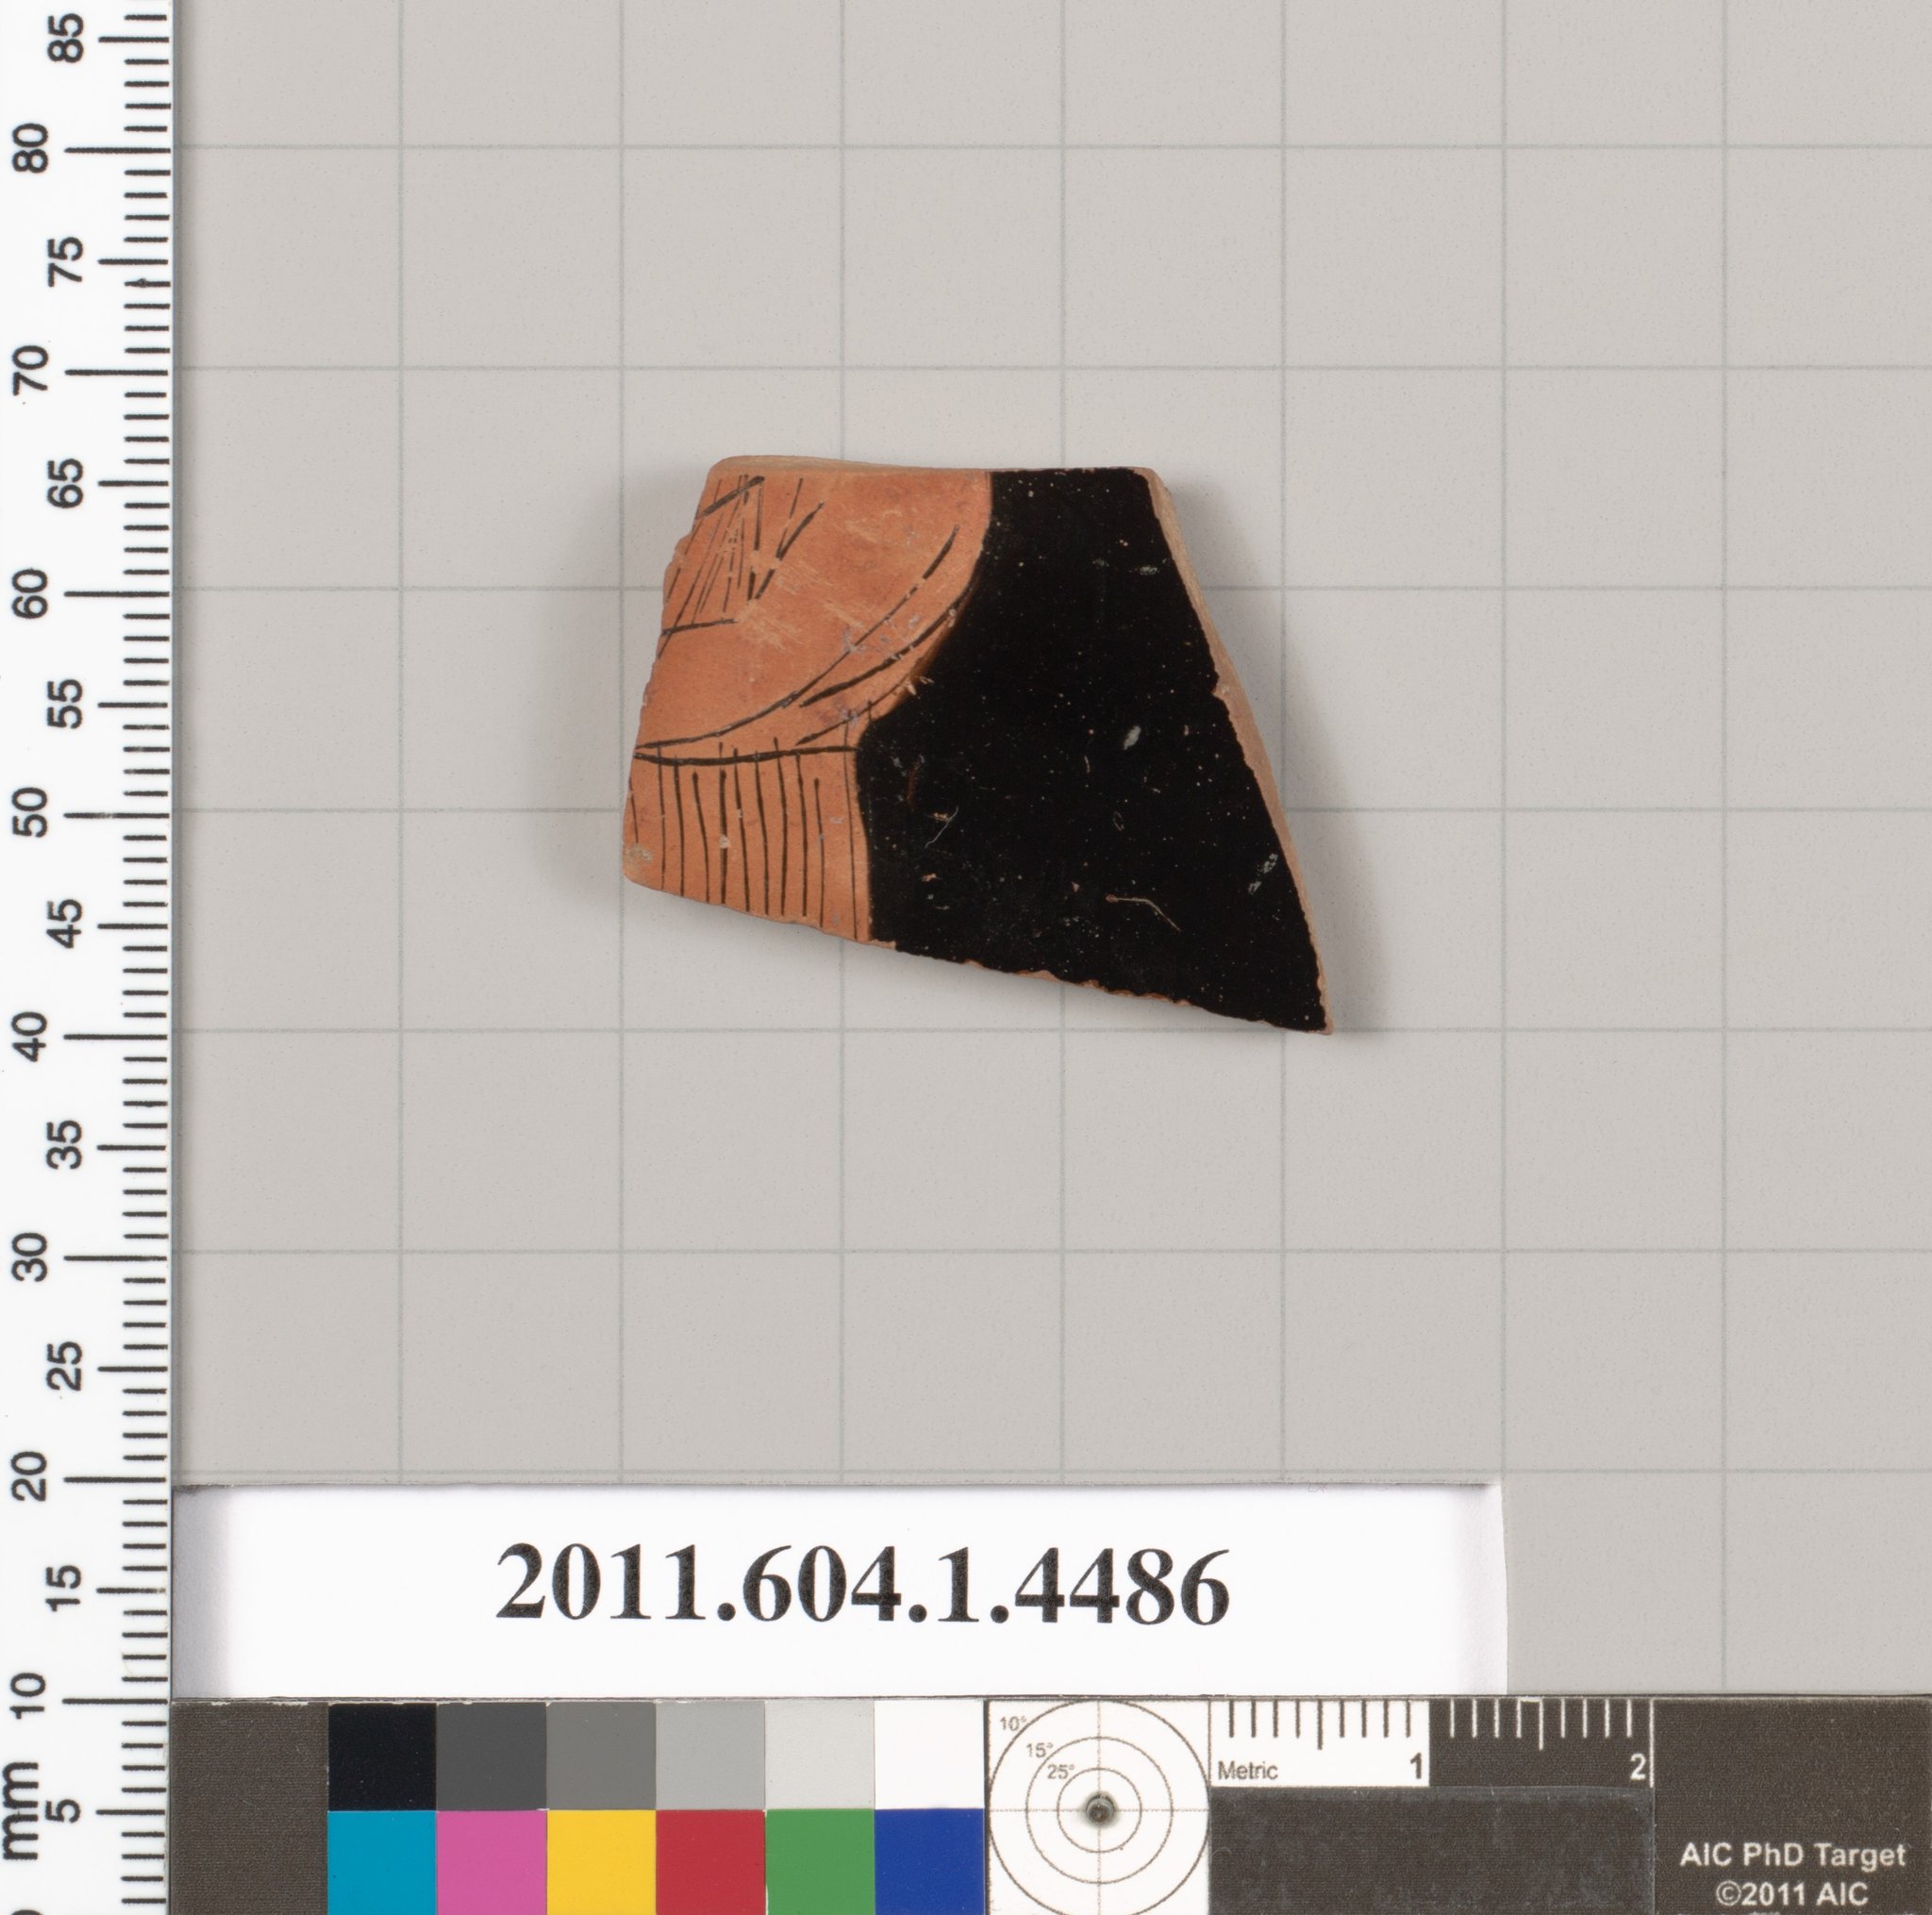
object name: kylix fragment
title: Terracotta fragment of a kylix (drinking cup)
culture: greek, attic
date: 480-470 BCE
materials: terracotta